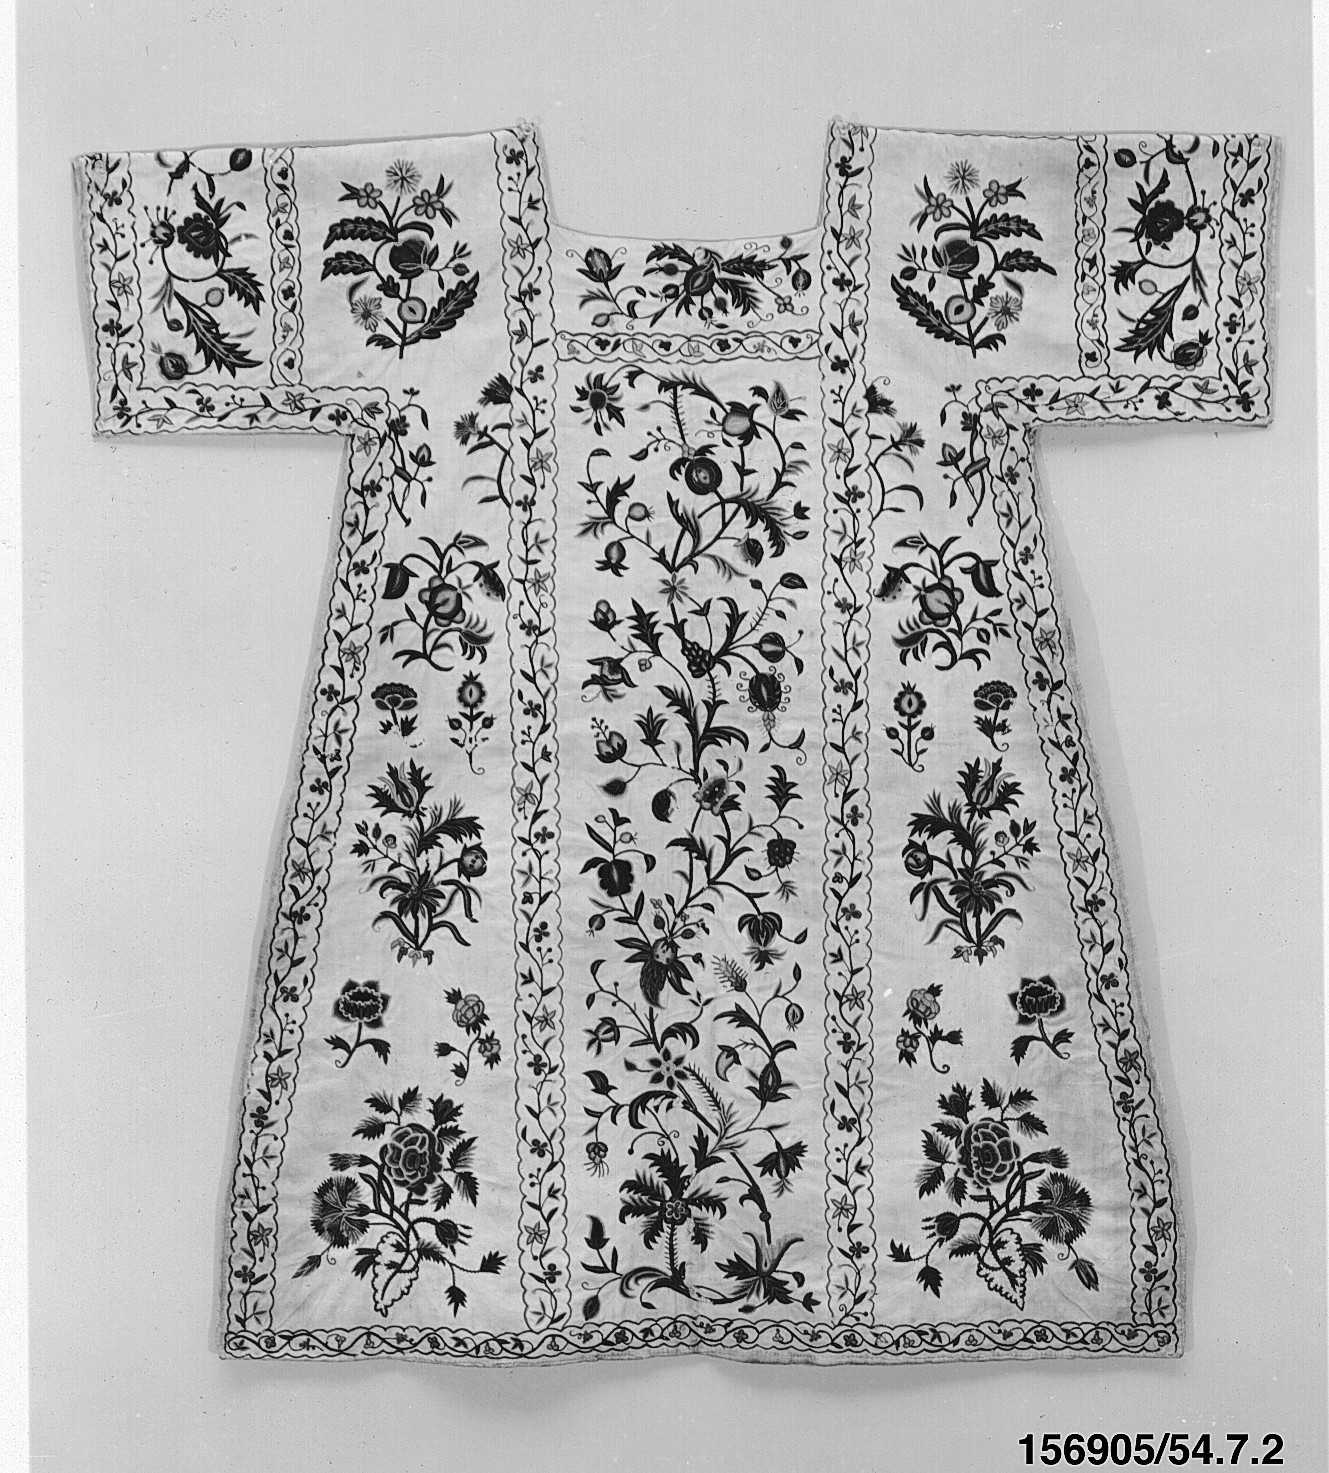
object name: dalmatic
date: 1701-1750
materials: linen, wool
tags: flowers,leaves